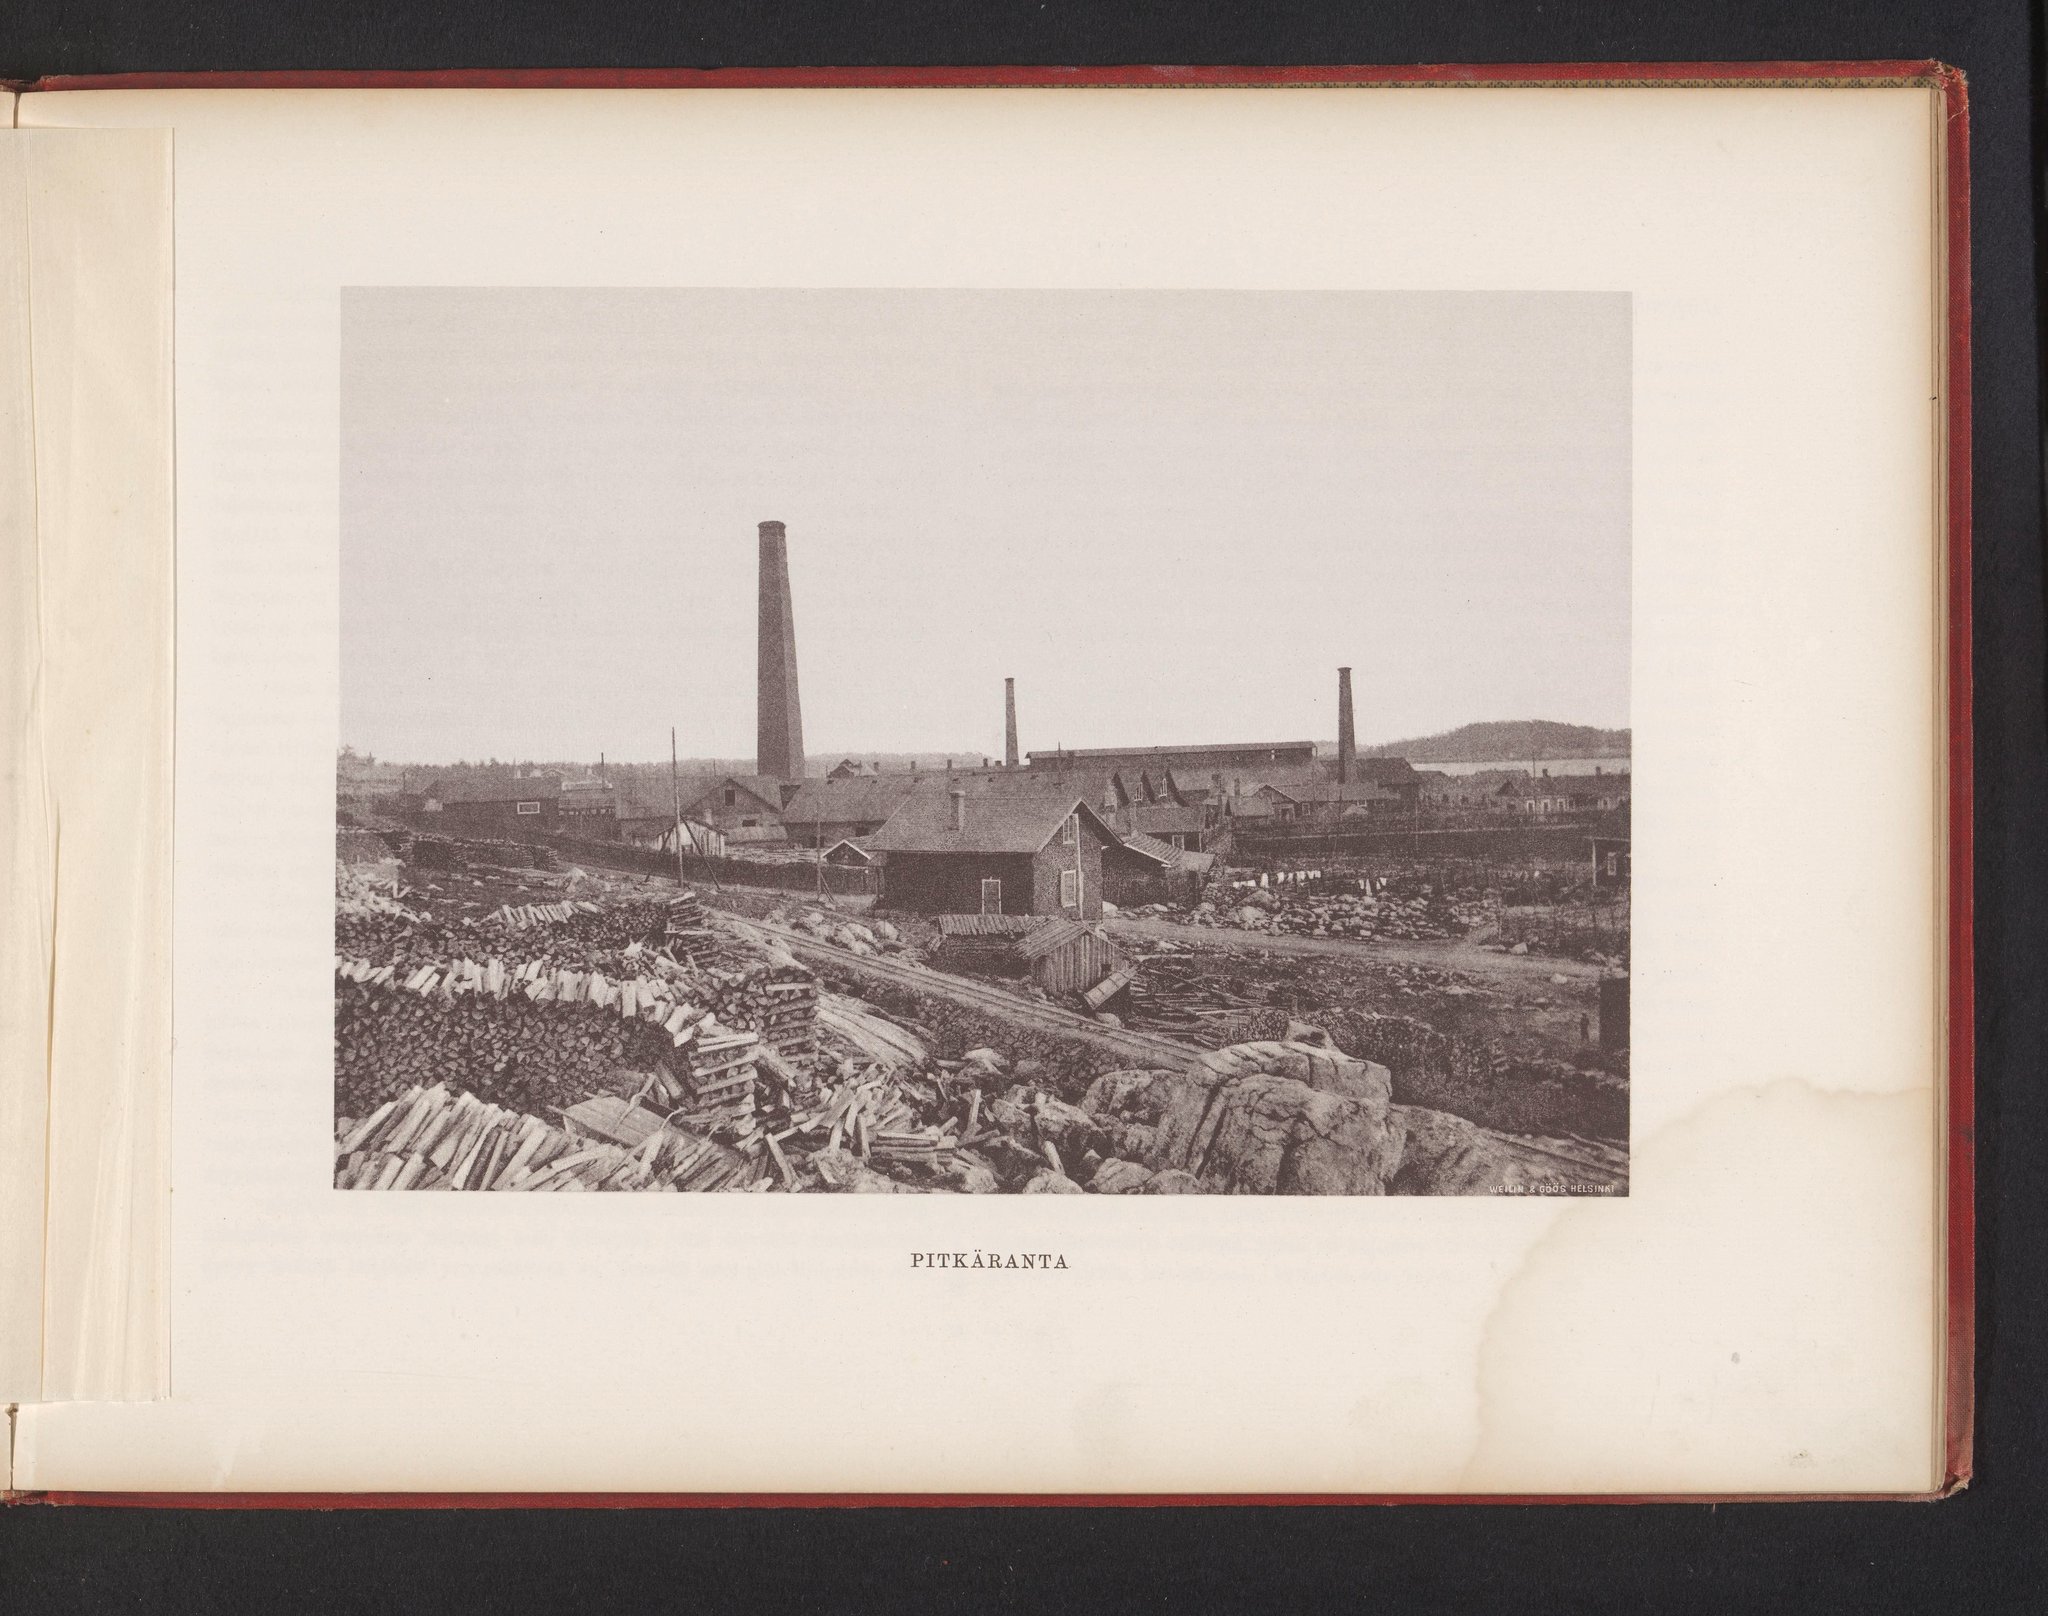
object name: page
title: Schoorstenen bij gebouwen en stapels hout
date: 1888-1893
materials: paper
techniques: autotype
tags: chimney, industries ~ plant material, civic architecture; edifices; dwellings